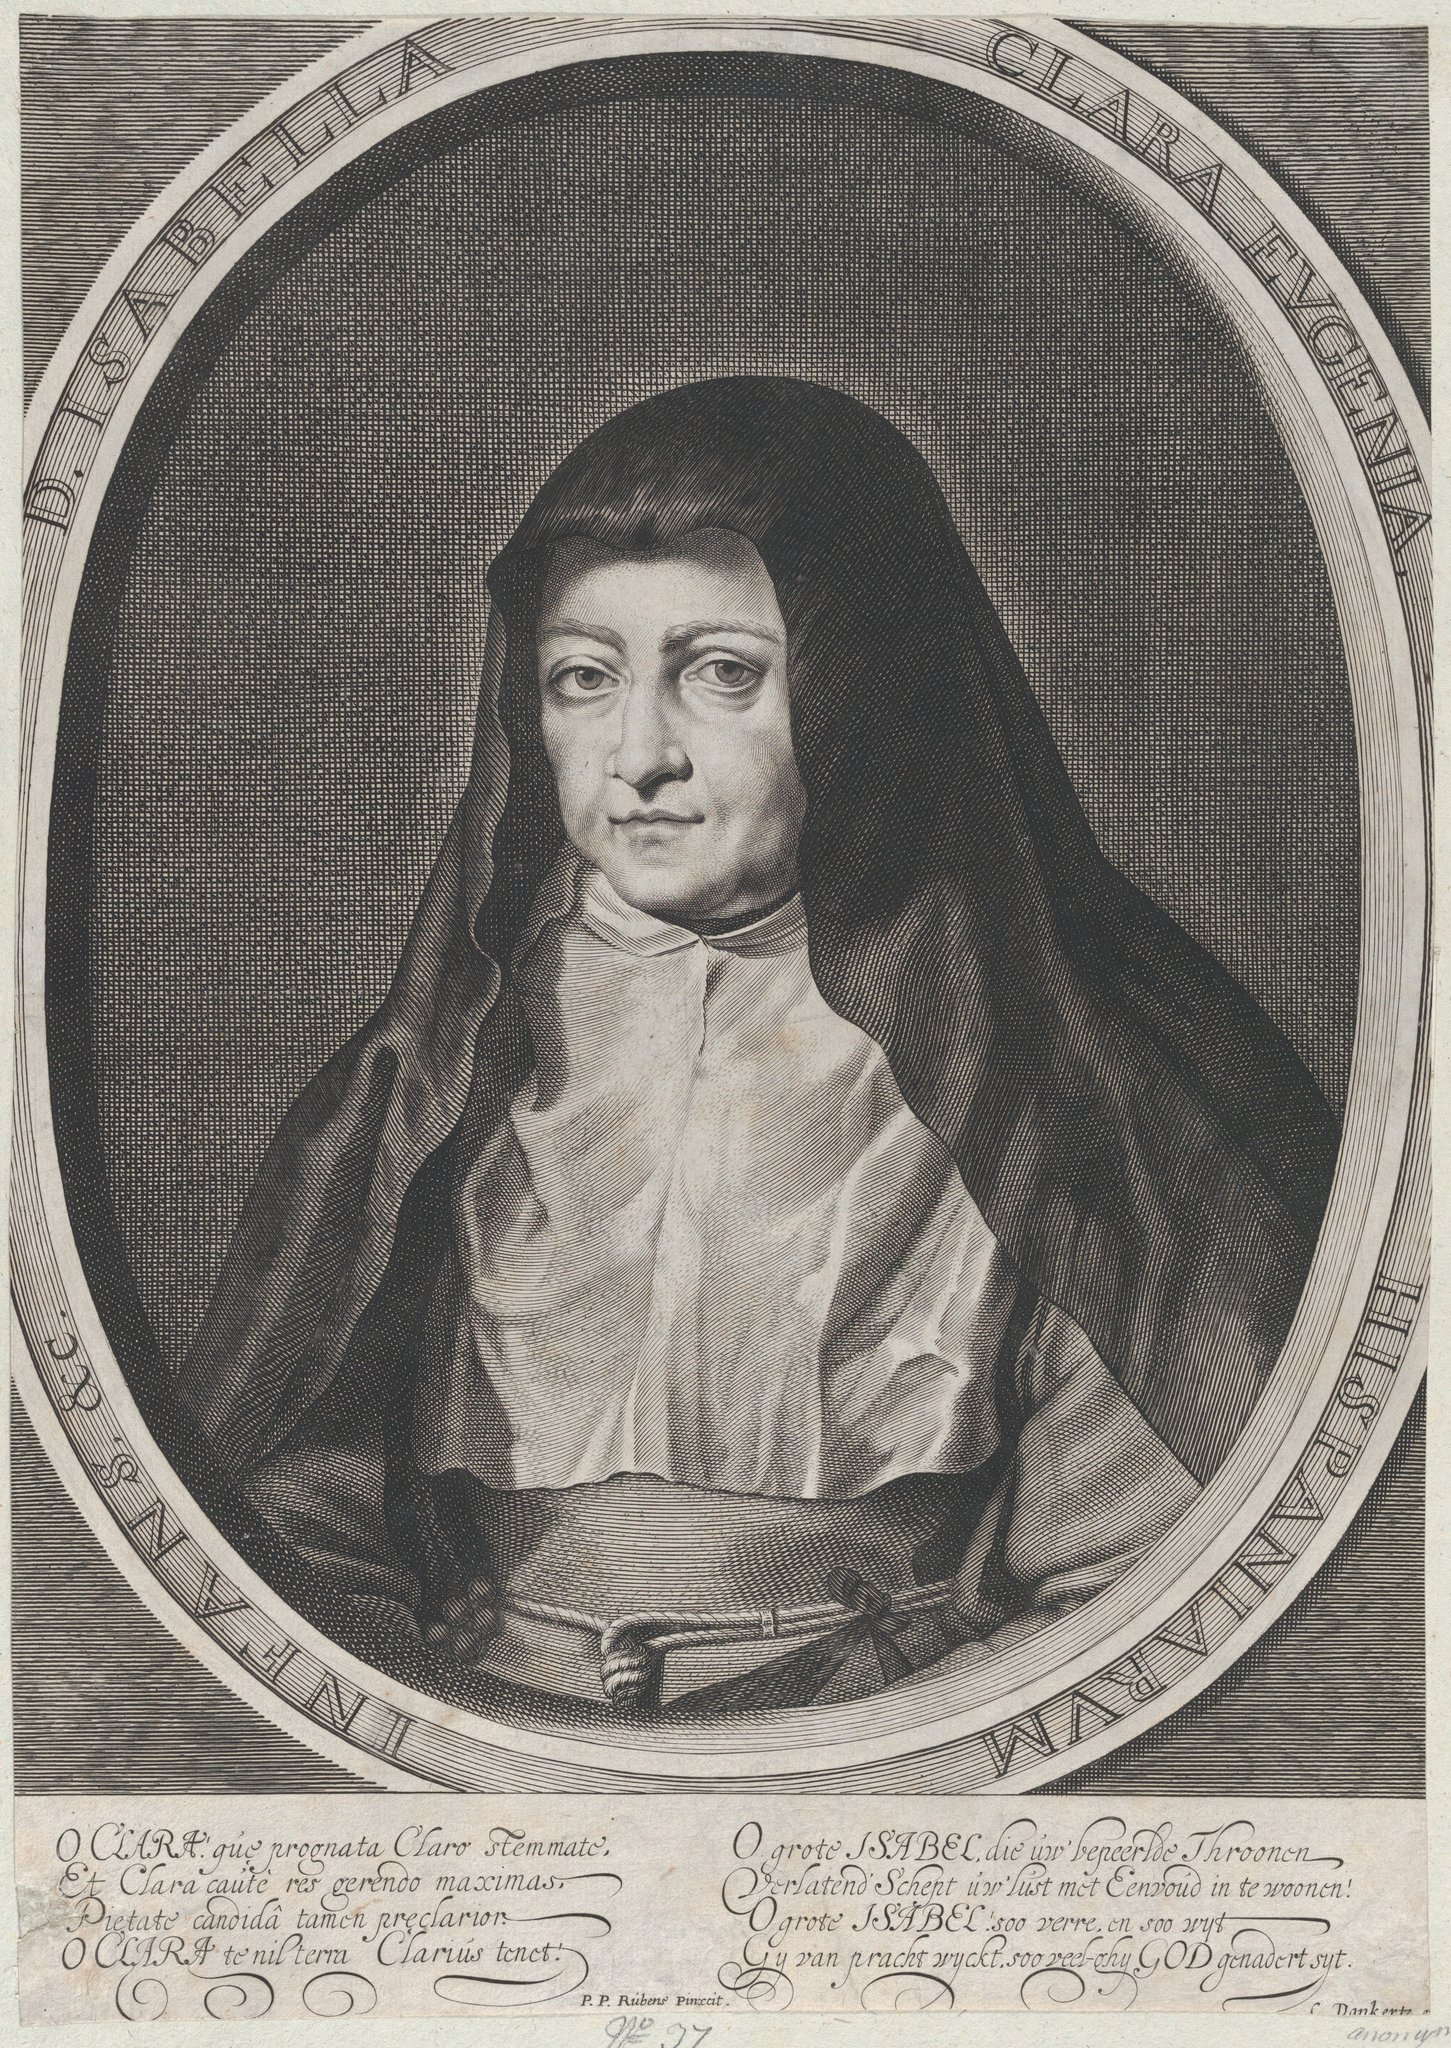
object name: print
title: Portrait of Archduchess Isabella Clara Eugenia, Spanish Regent of the Low Countries, as a Nun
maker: Anonymous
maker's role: artist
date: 1628-1656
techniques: engraving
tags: portraits,women